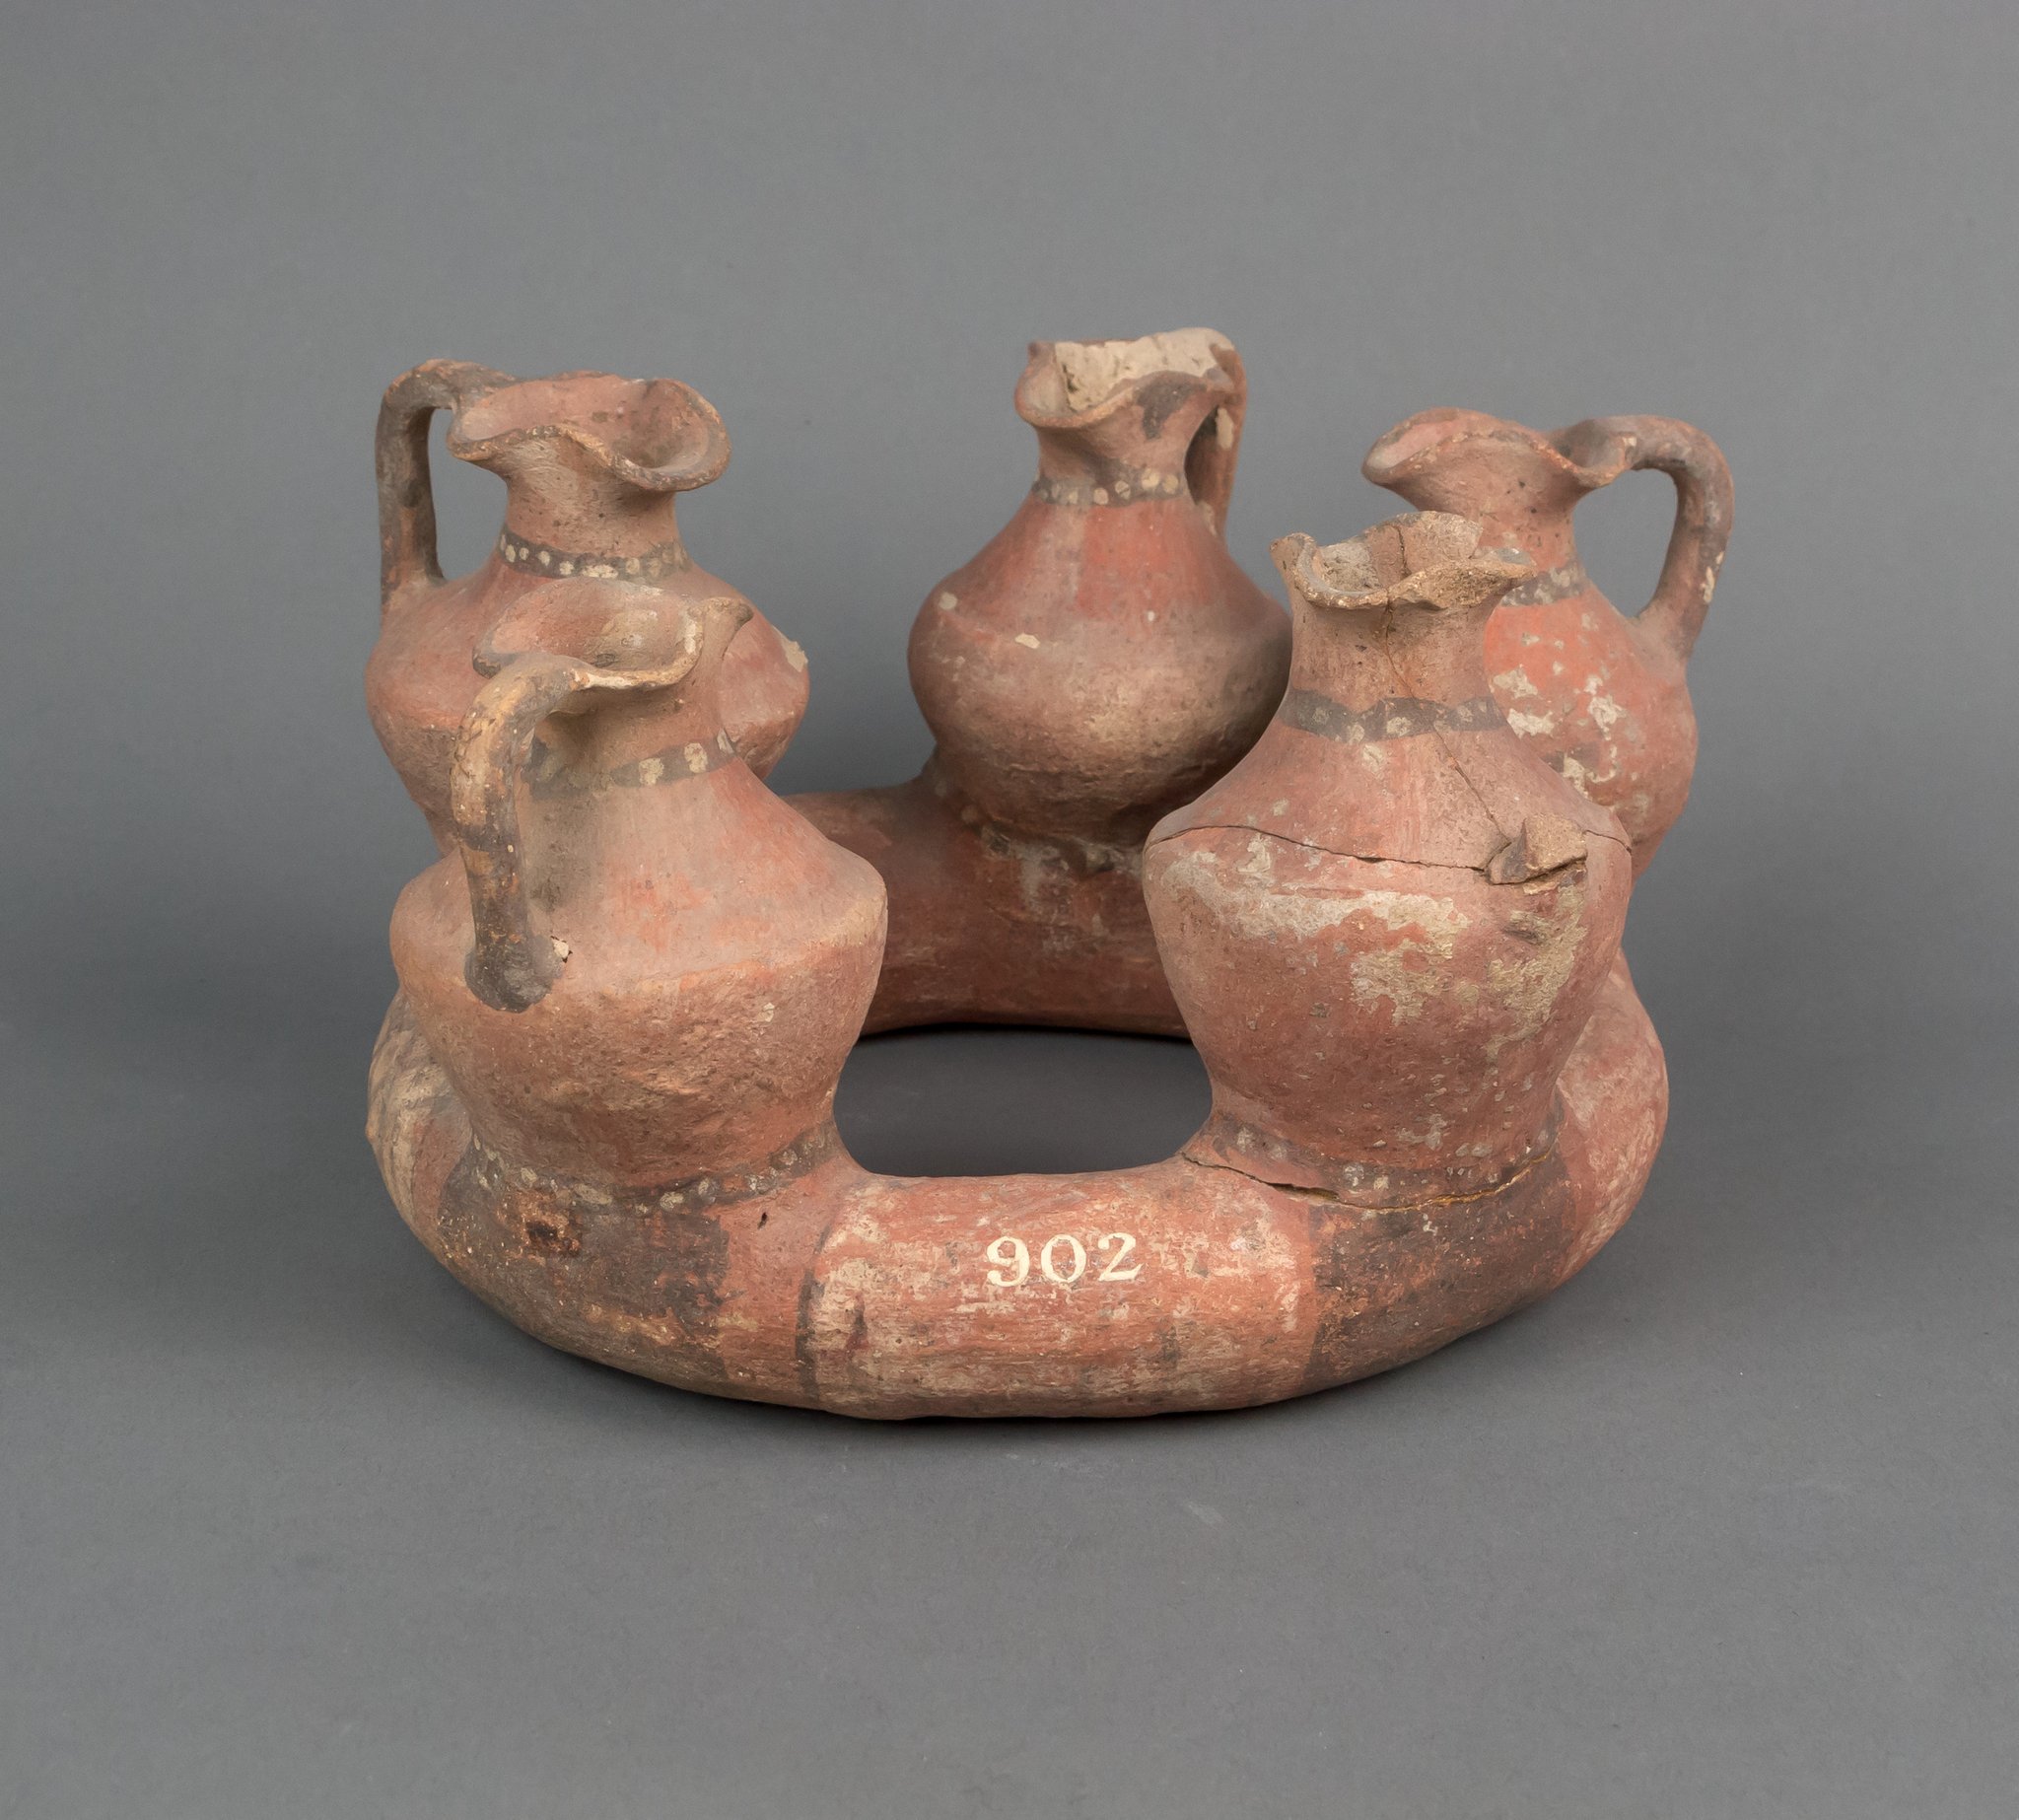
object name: ring kernos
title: Ring-kernos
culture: cypriot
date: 600-480 BCE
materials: terracotta